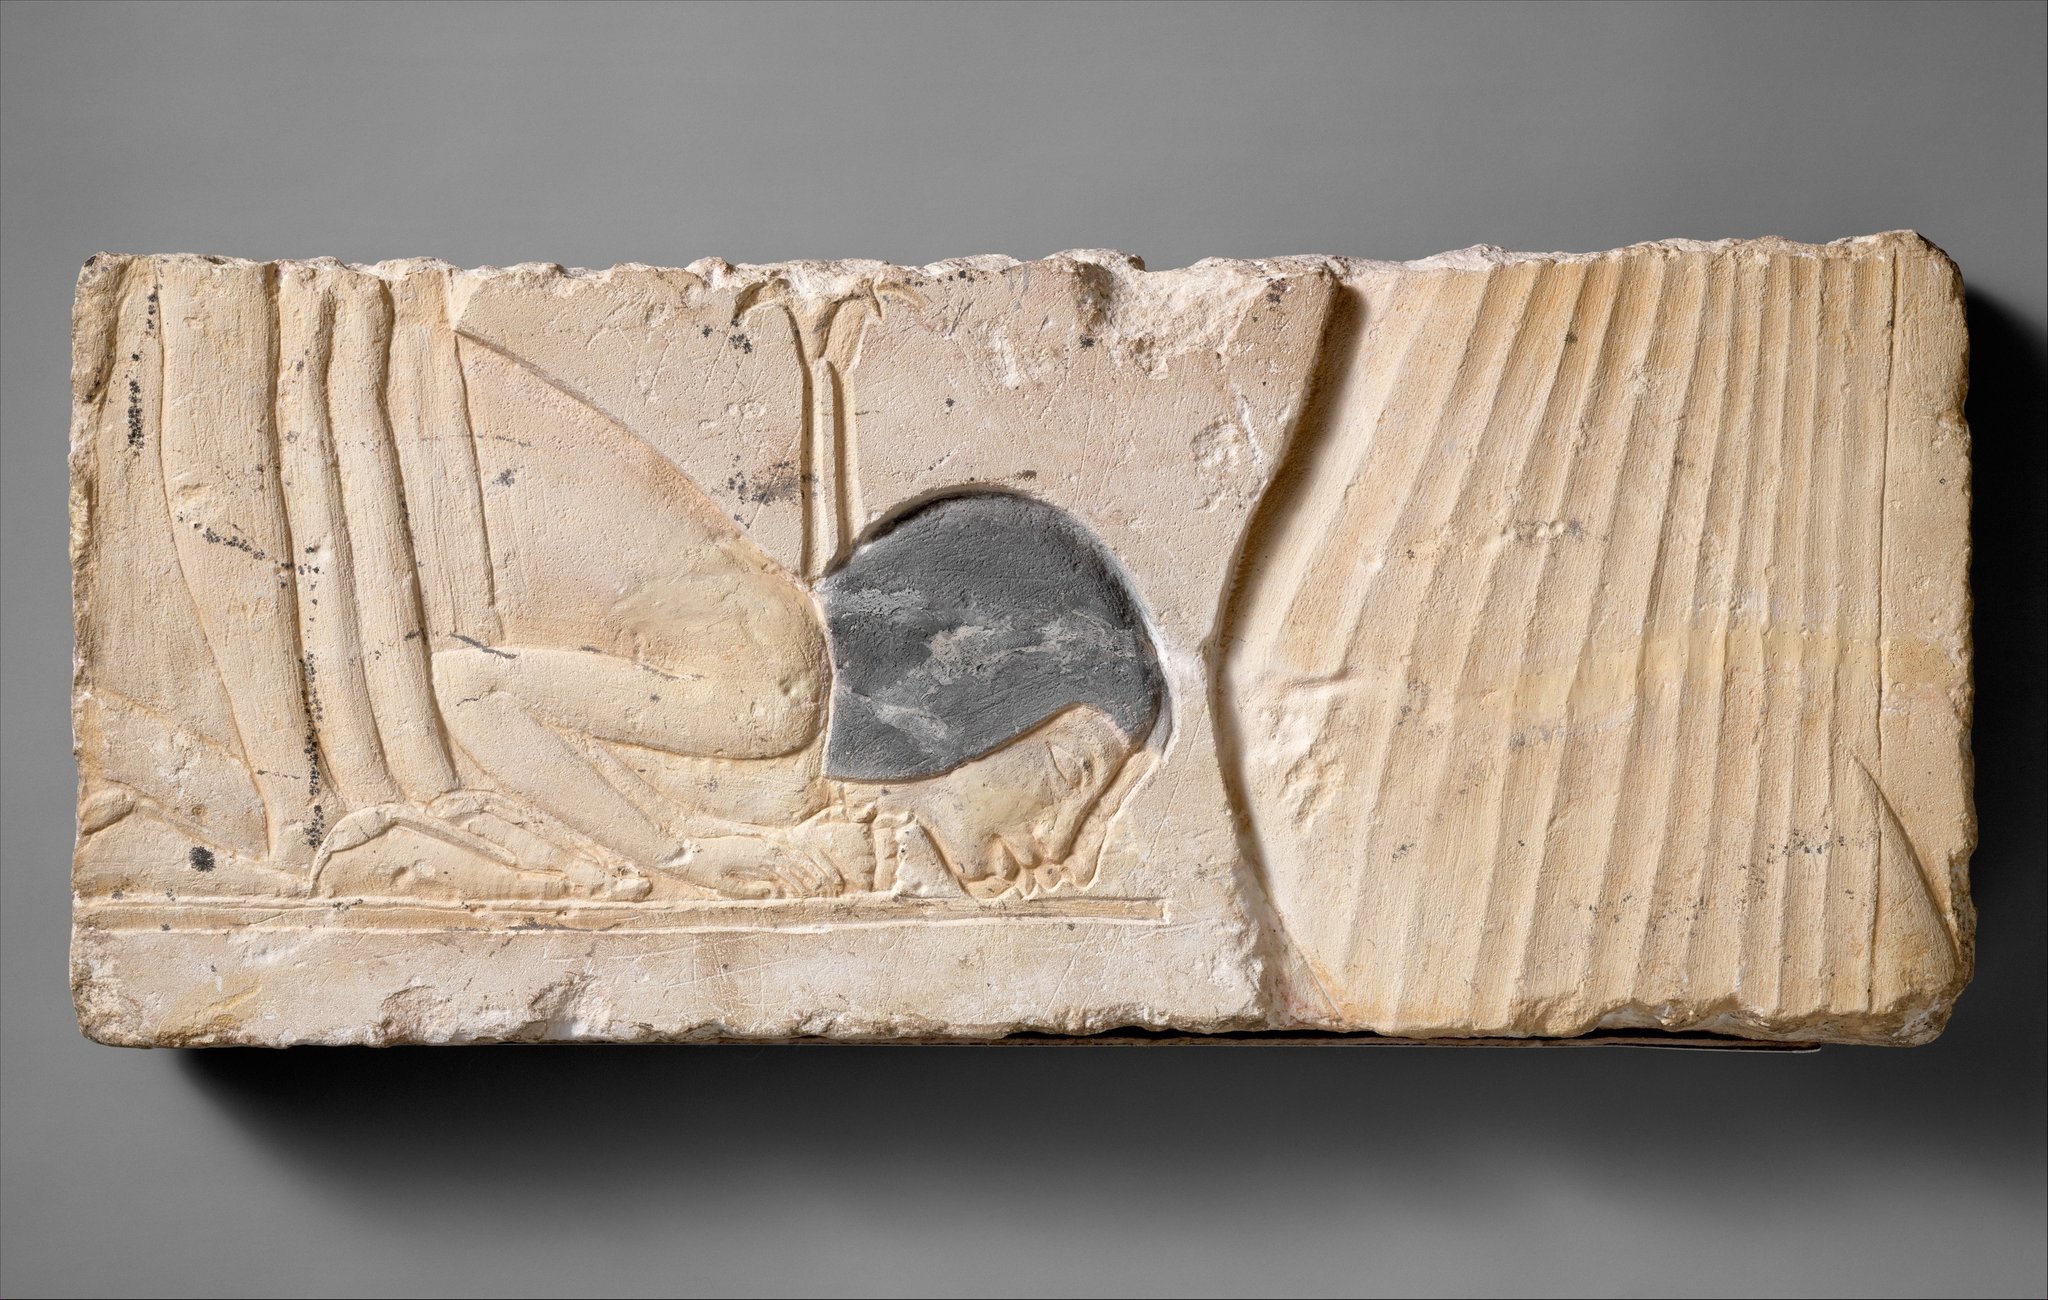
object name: talatat, courtier, nefertiti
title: Two bowing courtiers behind Nefertiti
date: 1353-1336 BCE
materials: limestone, paint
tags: men,women